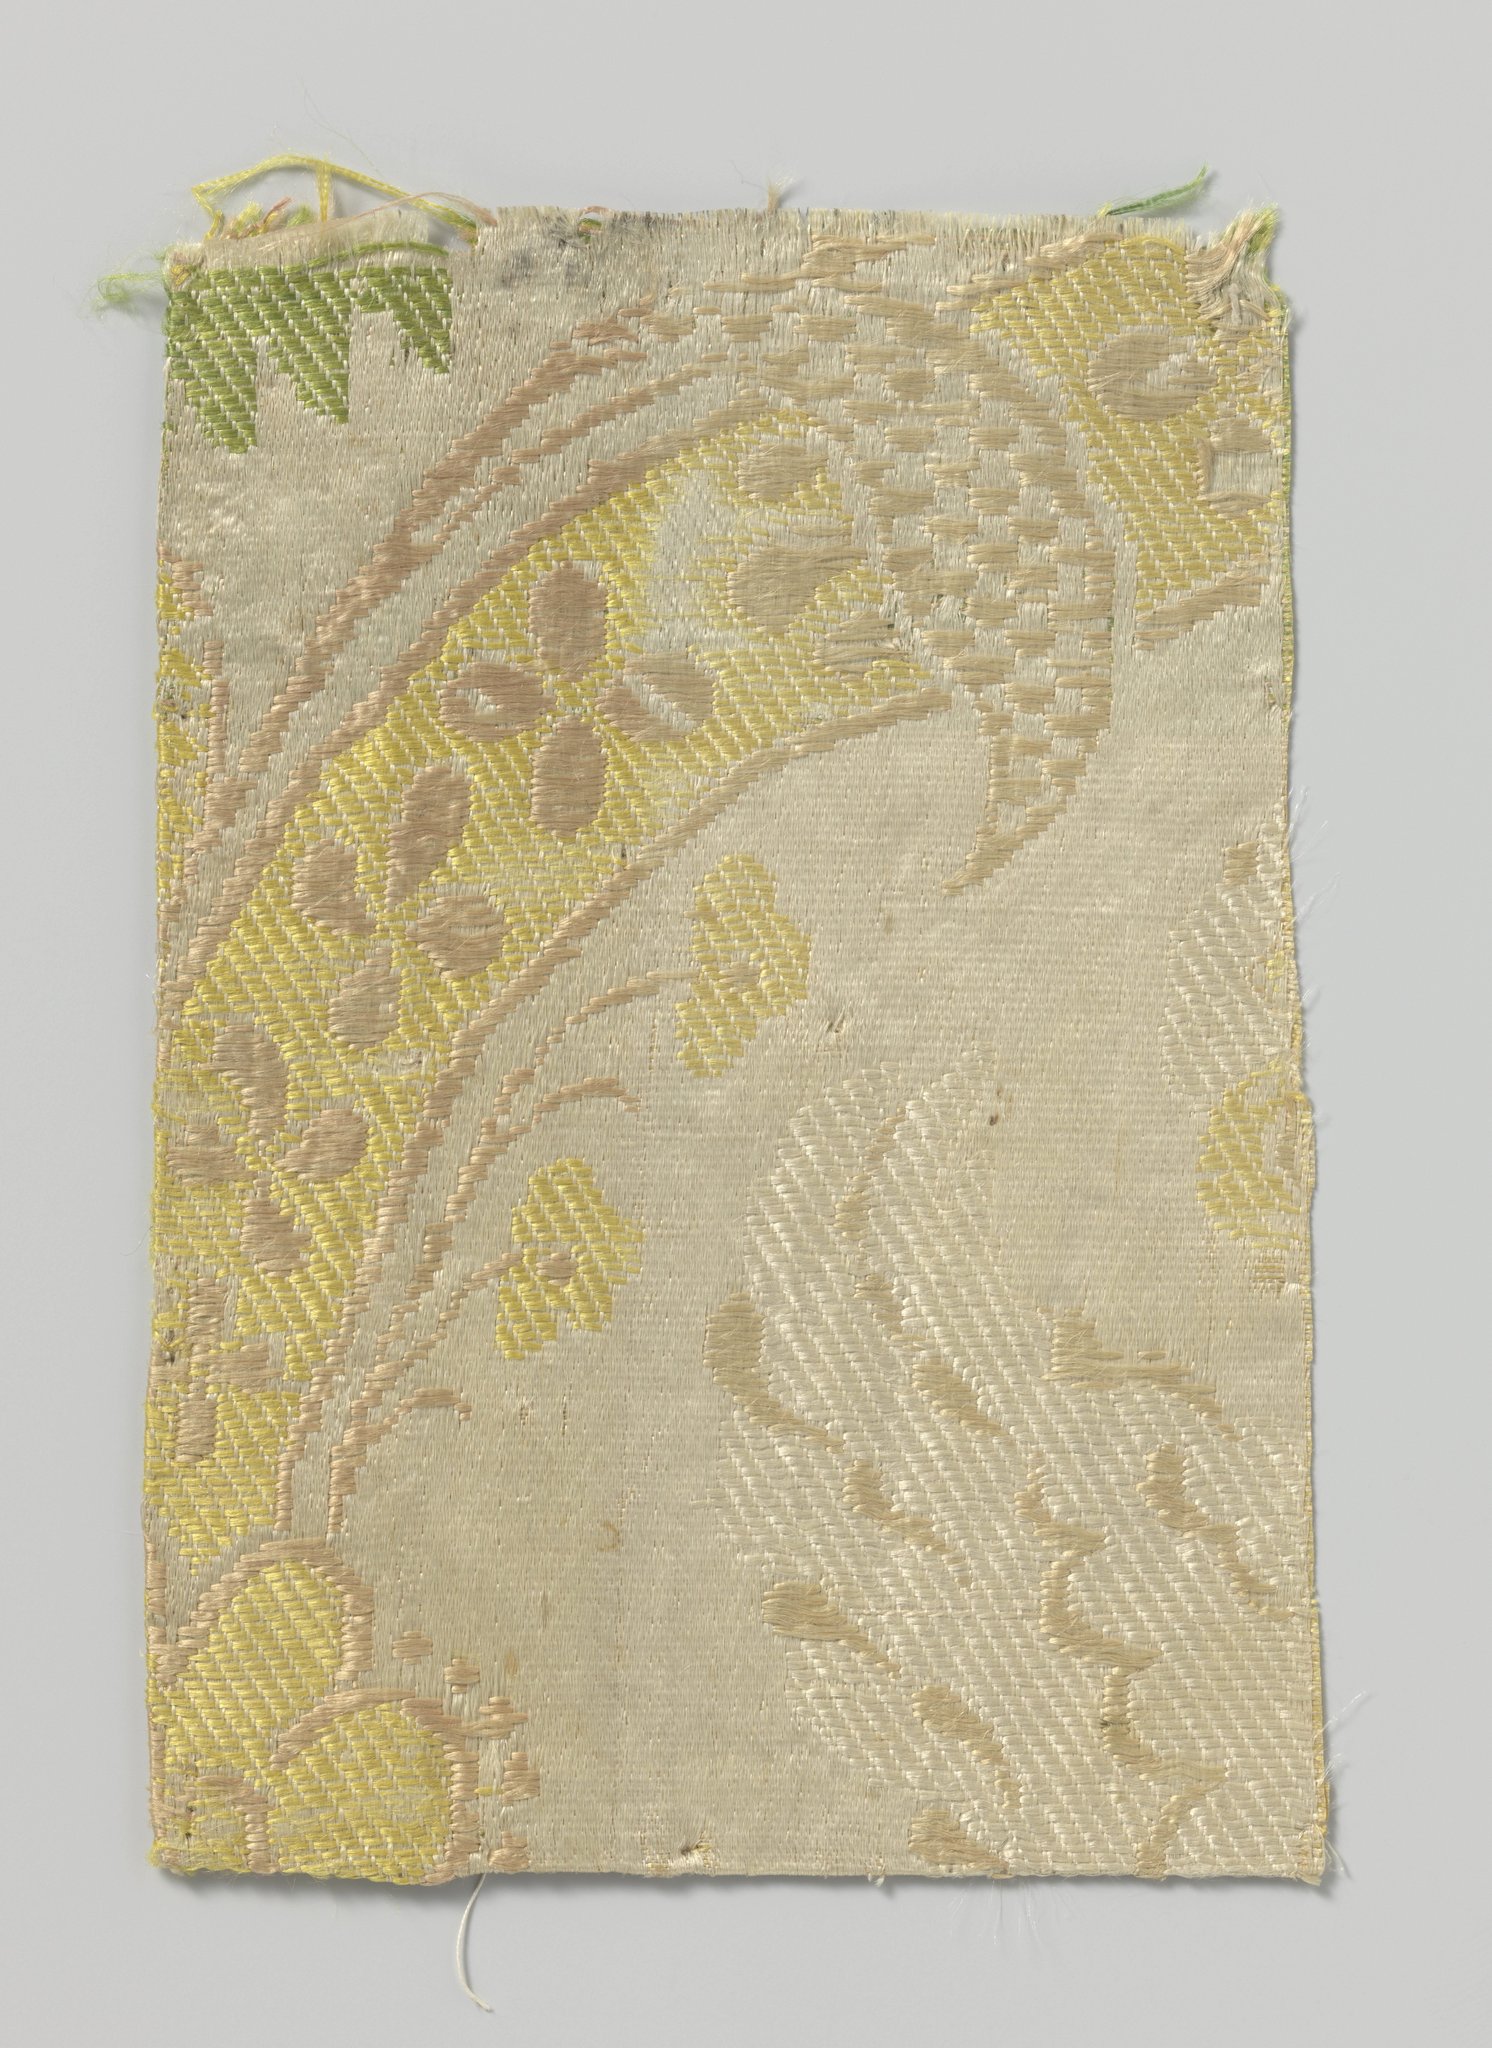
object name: fragment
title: Fragment lampas afgezet met keperband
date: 1575-1600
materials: silk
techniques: lampas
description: Fragment met slechts een deel van het patroon zichtbaar: bandwerk met uiteinde van een vleugel. Fragment is afgezet met keperband.